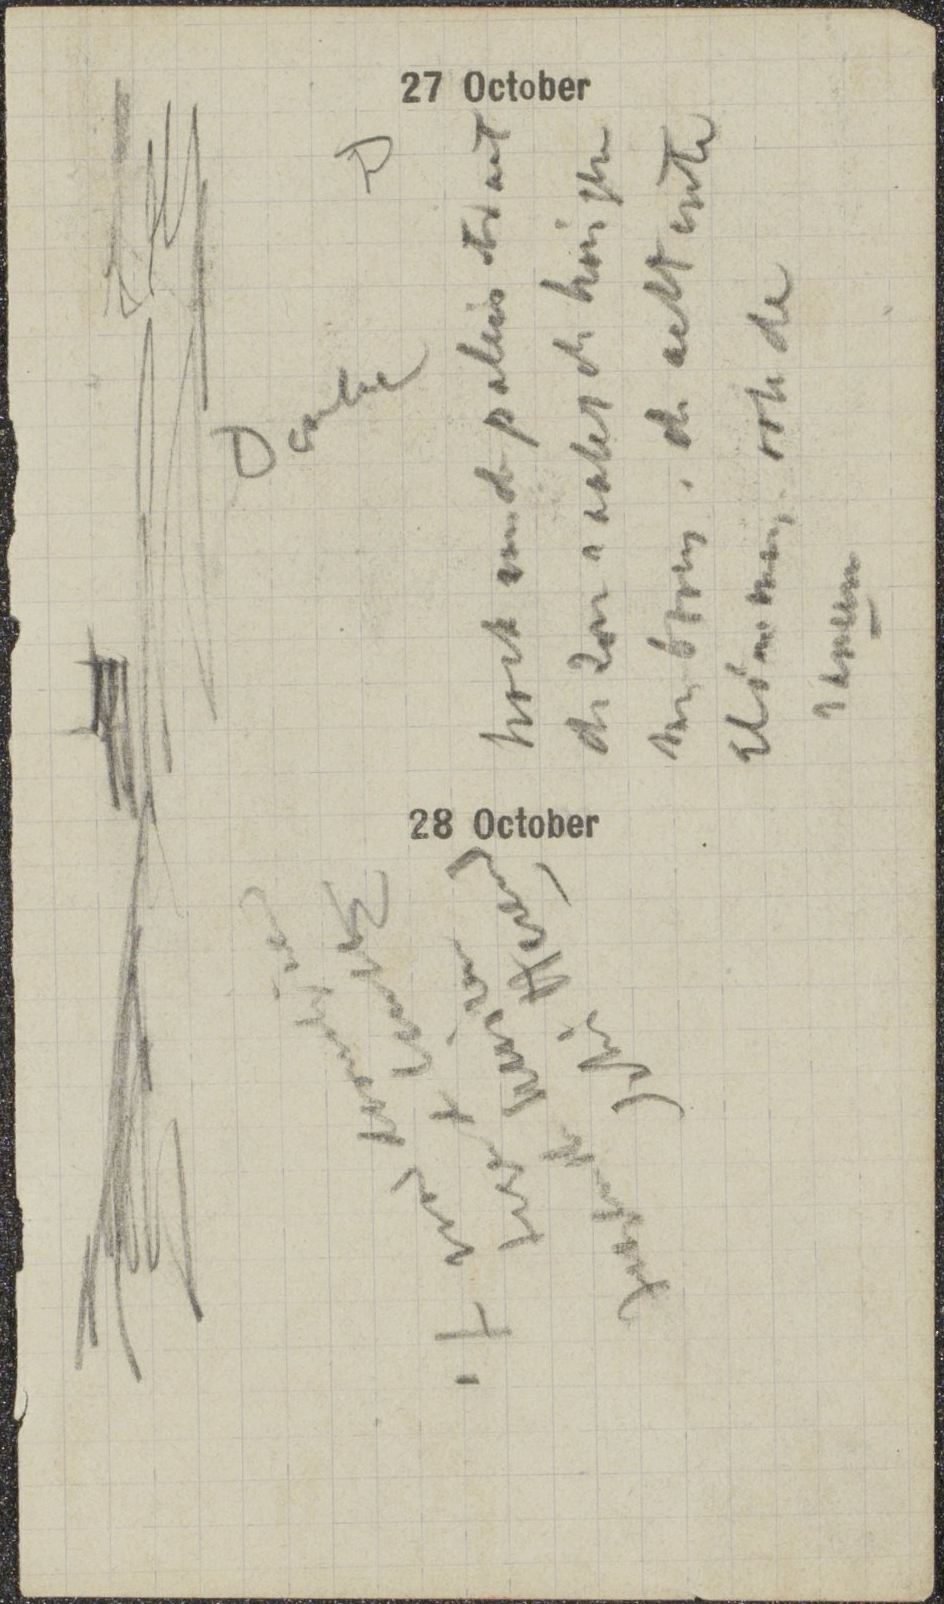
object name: drawing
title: Deel van een gevel in de Paleisstraat te Amsterdam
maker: george hendrik breitner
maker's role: draughtsman, painter, print maker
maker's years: 1857-1923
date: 1886-1923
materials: chalk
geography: amsterdam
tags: façade (of house or building)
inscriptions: annotation: ‘hoek van de Paleisstraat/ de zon raakt de huizen/ van boven, de achterste/ glimmen, ook de/ ramen’, : ‘'t rood doorschijnend/ tegen de lucht/ tegen de huizen/ schitterend/ Donker’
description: Op een agendablad. Hoort bij RP-T-1949-178-8.